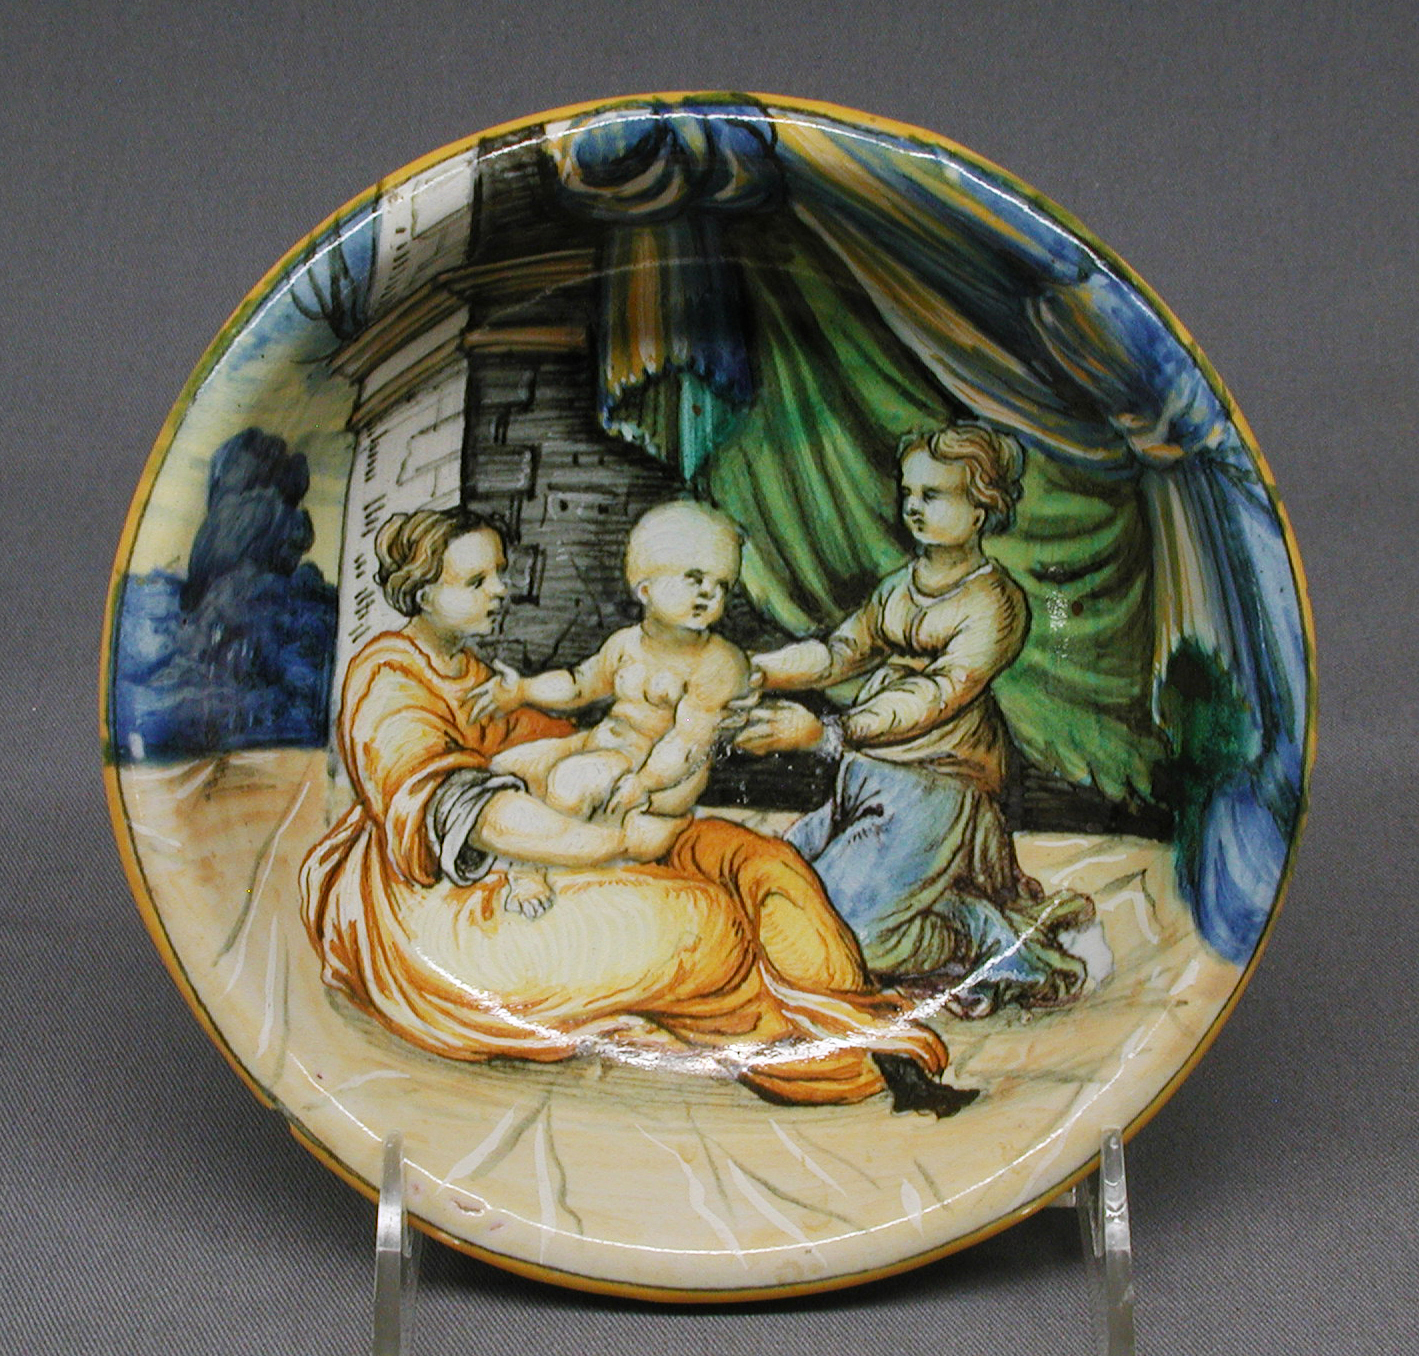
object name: bowl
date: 1560-1570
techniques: maiolica, glazing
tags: infants,women